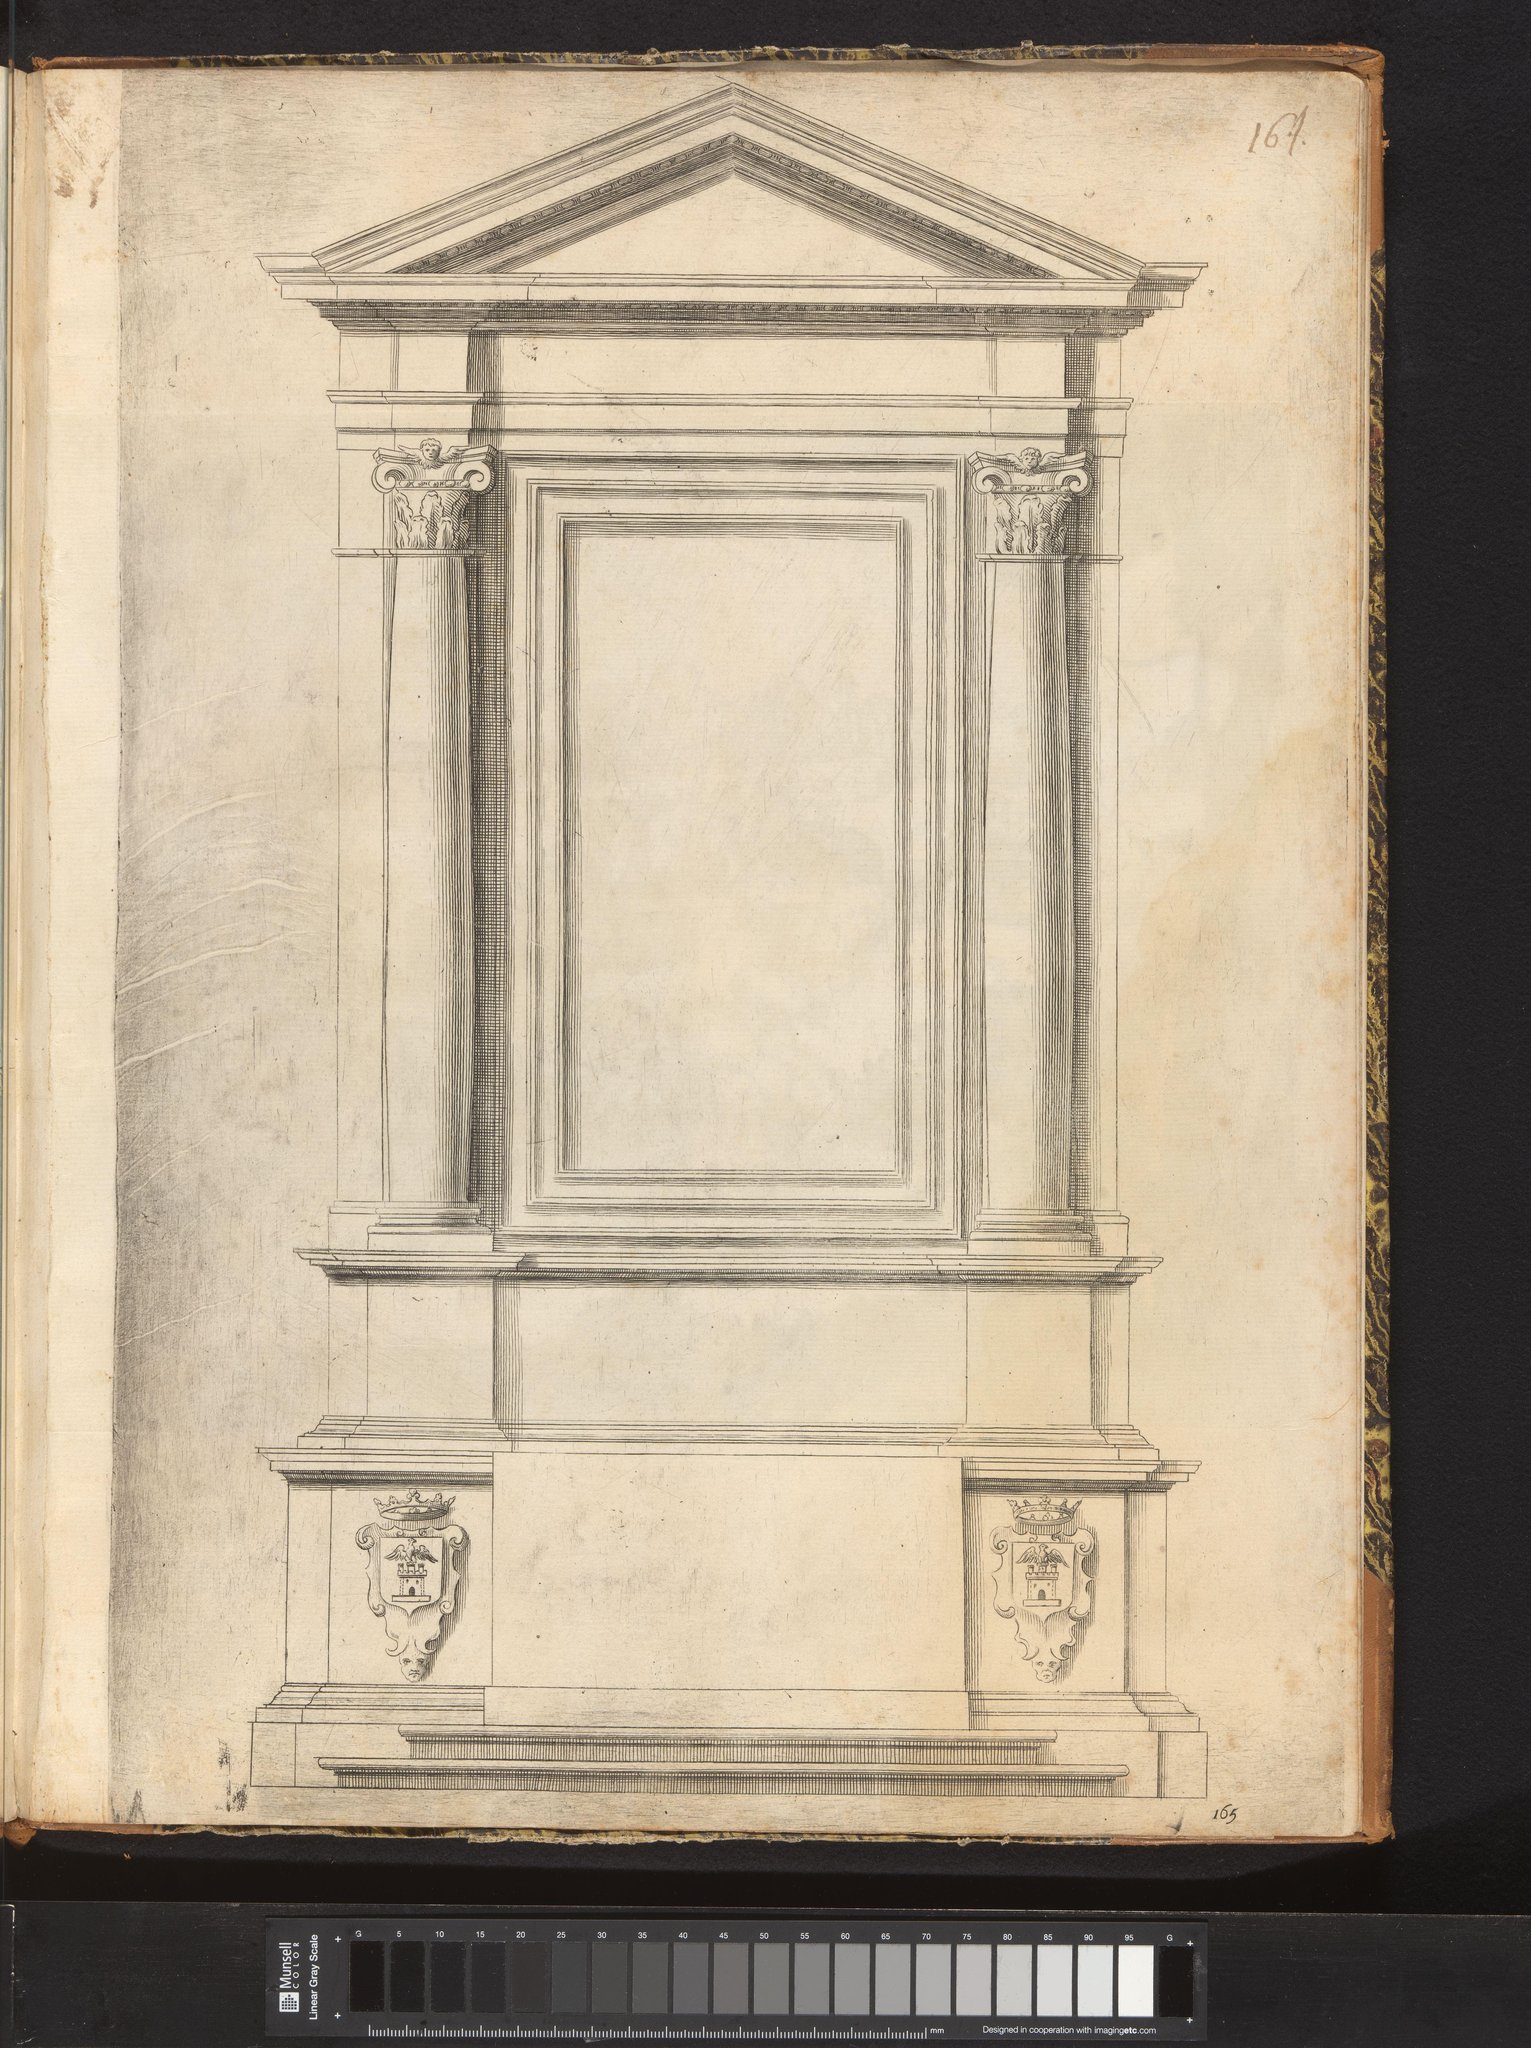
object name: album leaf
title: Galleria Giustiniana del Marchese Vincenzo Giustiniani II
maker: Anonymous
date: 1636-1647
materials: paper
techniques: engraving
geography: italy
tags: island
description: Gezicht op het eiland Chios in vogelvlucht. Midden boven een cartouche met een tekst in het Latijn. Het eiland Chios werd voor twee eeuwen geregeerd door de familie Giustiniani tot het jaar 1566. Prent maakt deel uit van een album met een serie prenten naar de sculpturen in de verzameling in de Galleria Giustiniani te Rome.